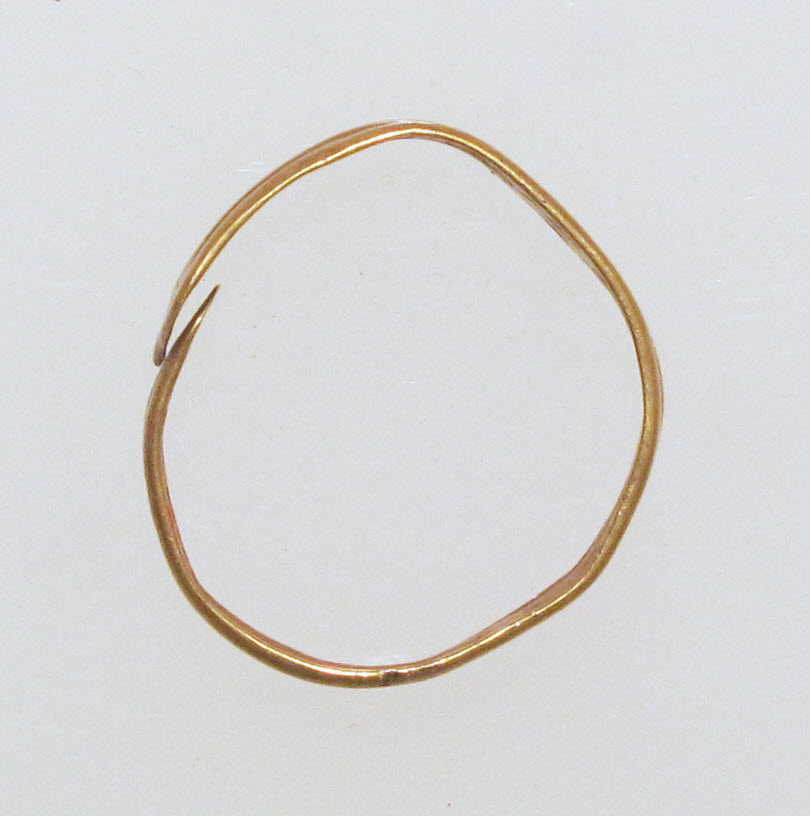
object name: ring, spiral with overlapping end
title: Ring, spiral with overlapping ends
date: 7000 BCE-330 CE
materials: gold